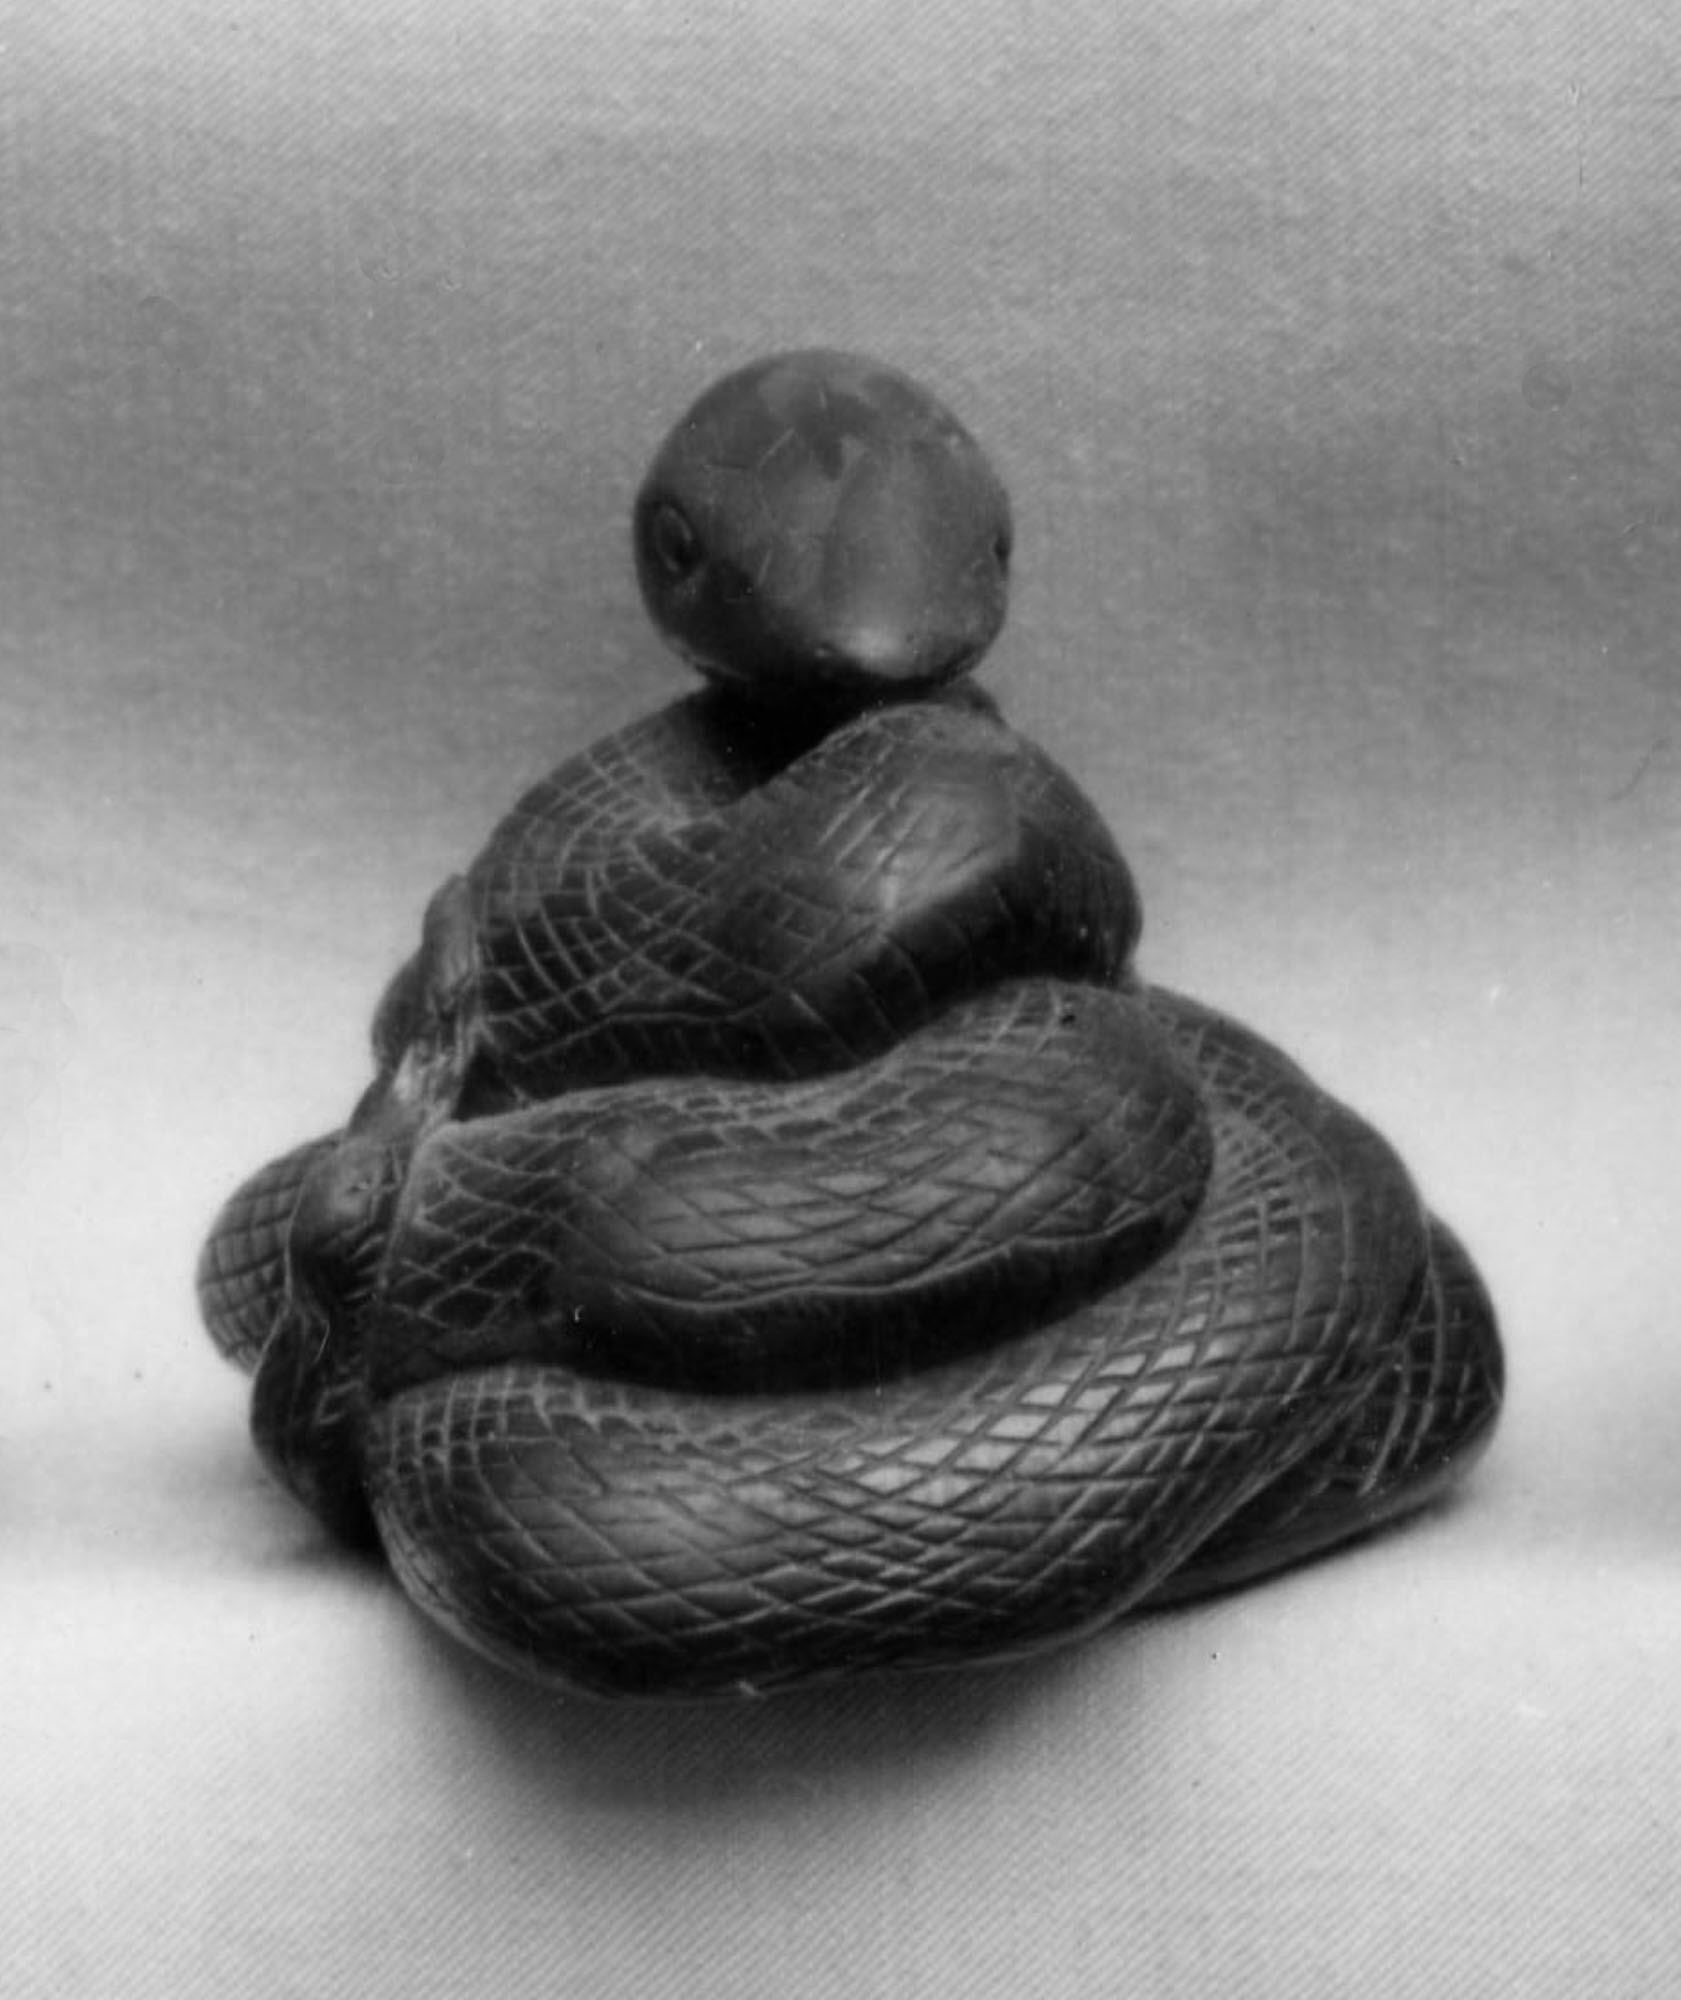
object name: netsuke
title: Netsuke of Snake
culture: japanese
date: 1701-1800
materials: wood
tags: snakes